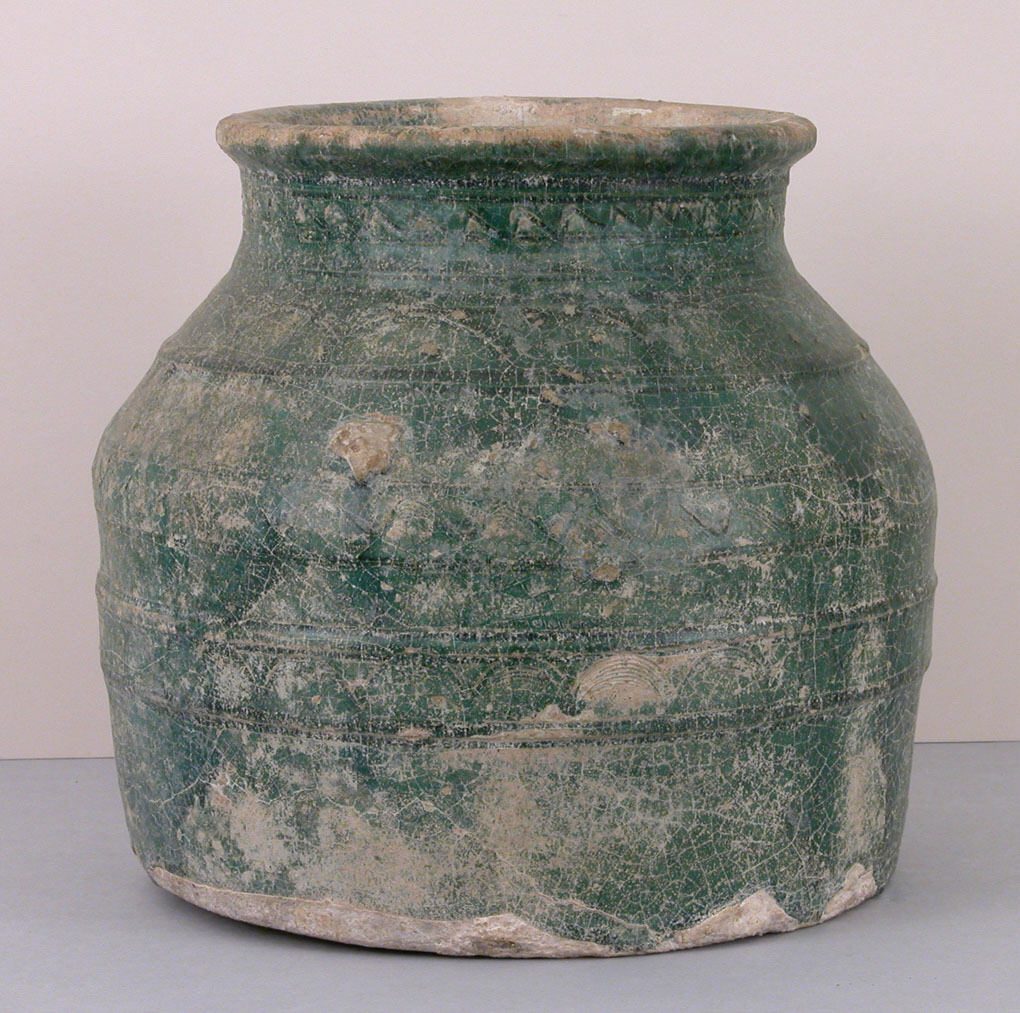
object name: jar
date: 701-900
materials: earthenware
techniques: glazing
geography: iran